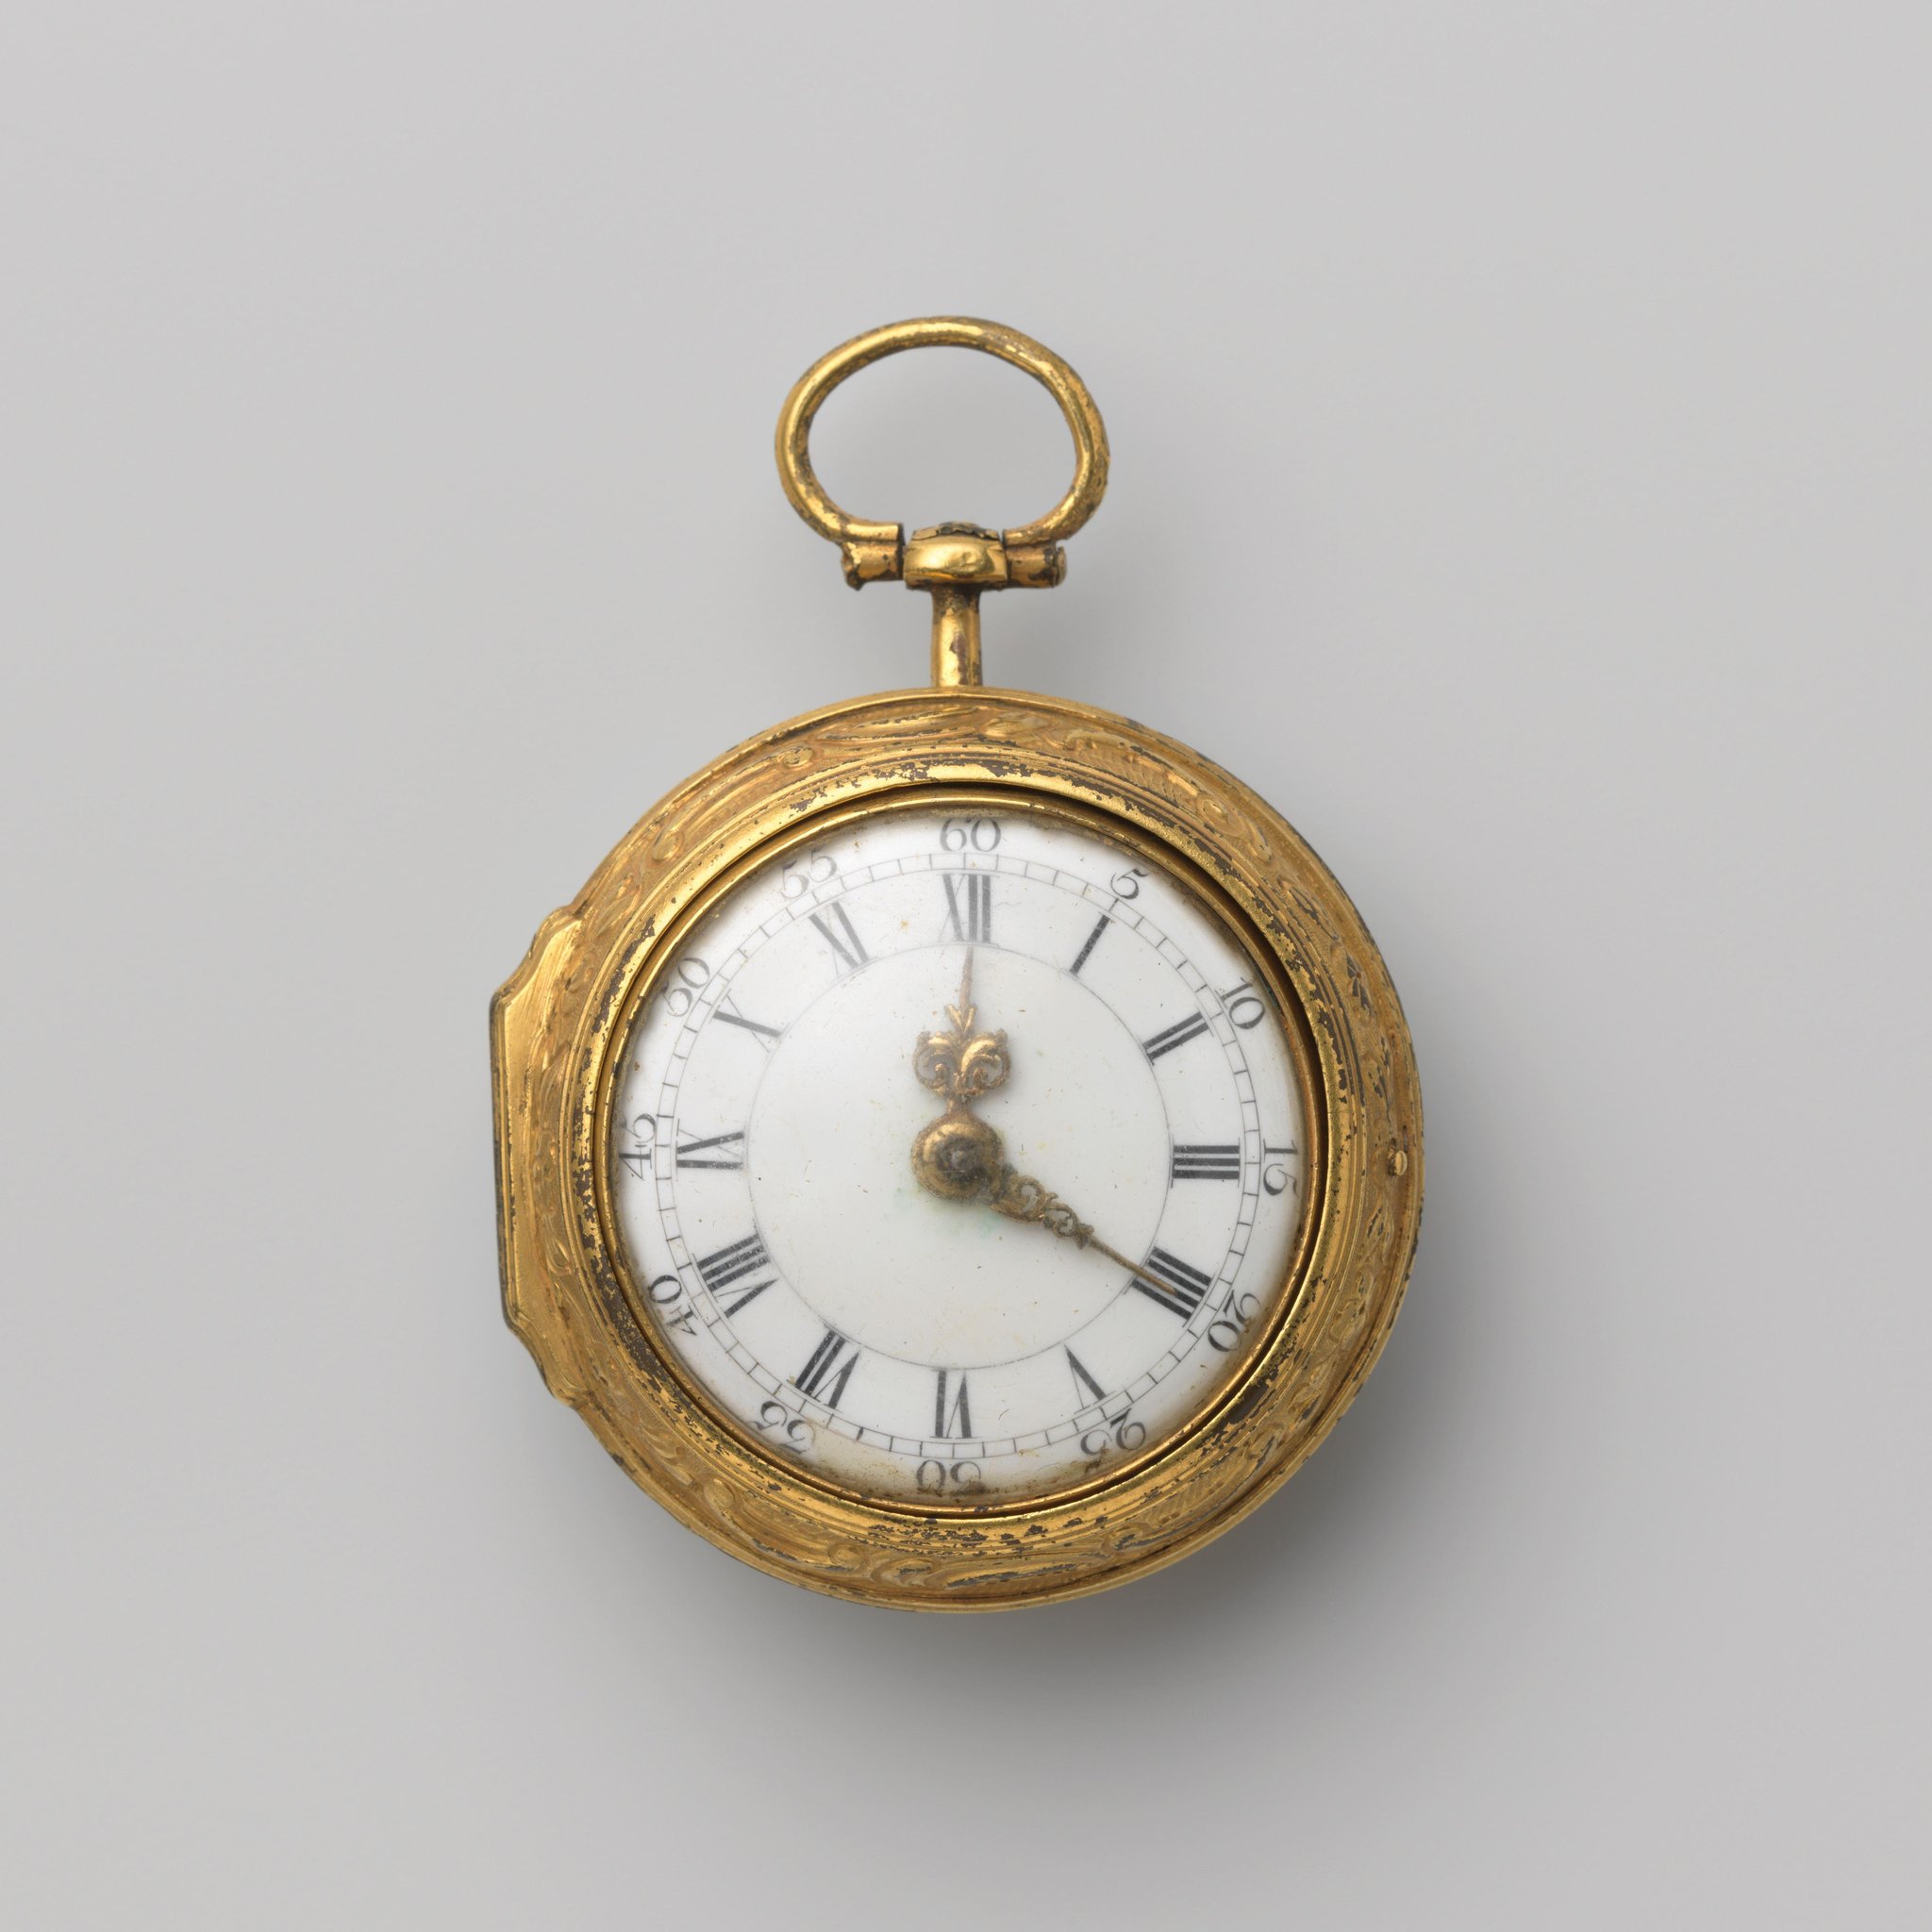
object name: wrist watch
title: Horloge van verguld koper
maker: t. moore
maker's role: clockmaker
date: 1750-1800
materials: copper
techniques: gilding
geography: london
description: Verguld koperen horloge met geëmailleerde wijzerplaat. In de buitenkast is een voorstelling gedreven van Minerva en Ceres.